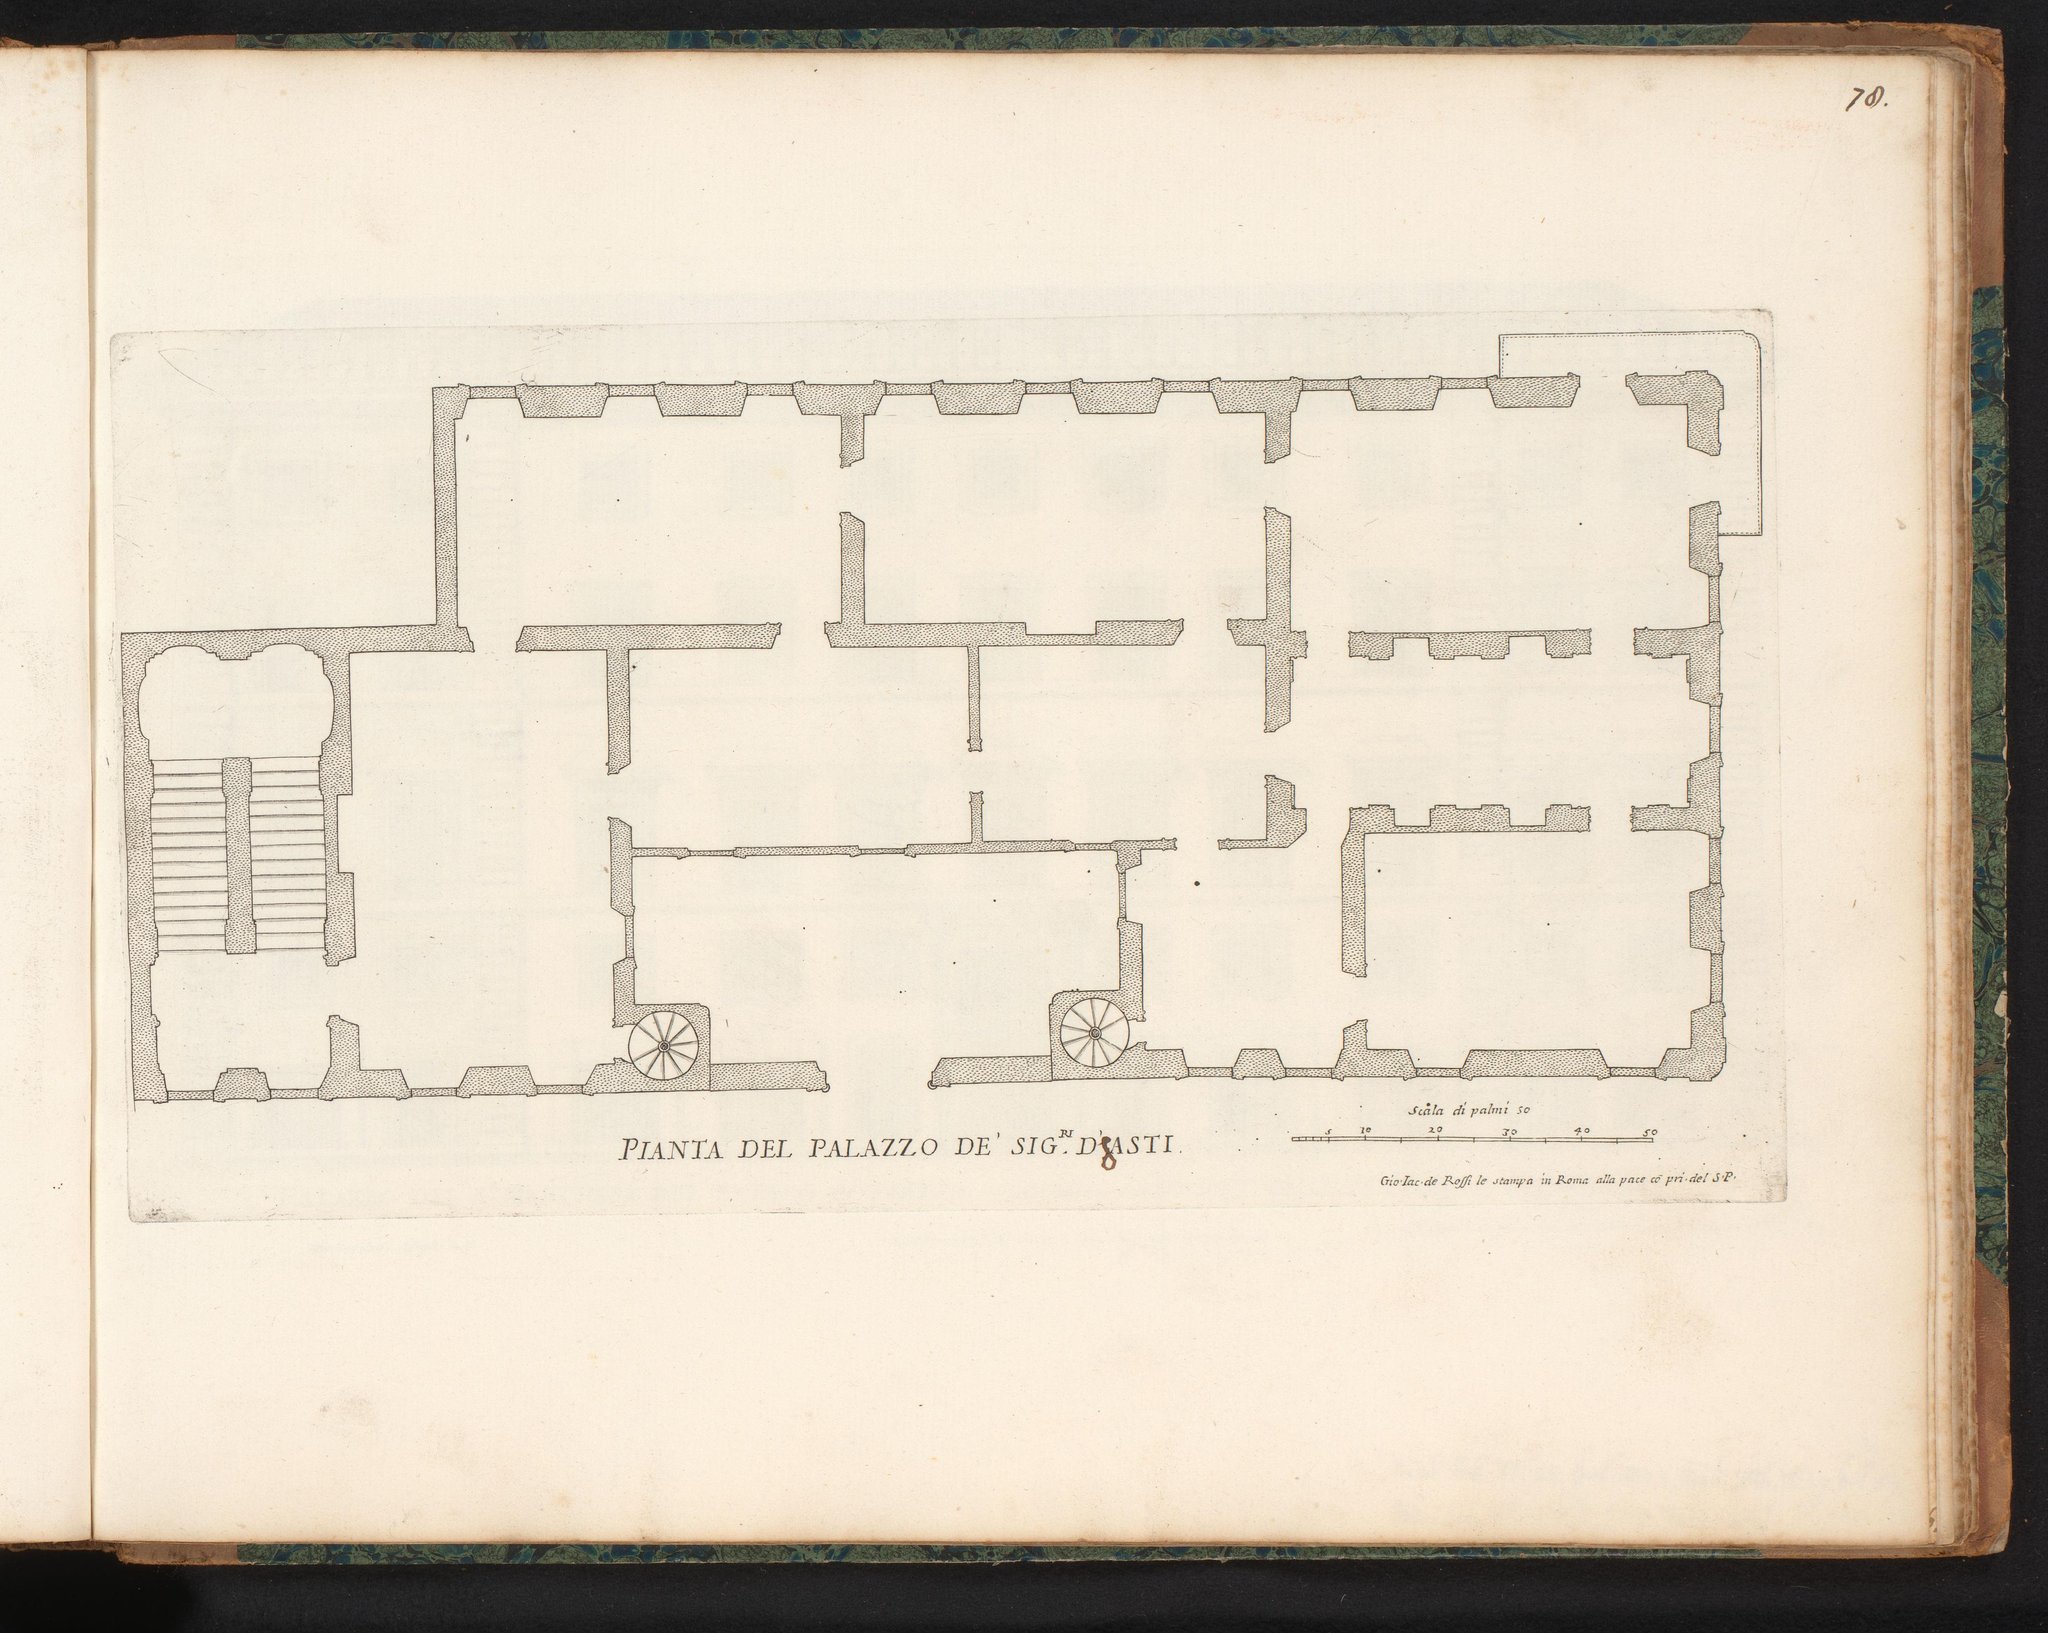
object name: print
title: Pianta del Palazzo de' sig.ri d'Asti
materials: paper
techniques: etching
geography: italy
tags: palace, plan ~ architecture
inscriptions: number: ‘78’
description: Deze prent maakt deel uit van de reeks getiteld: Palazzi di Roma. Deze reeks bestaat uit twee boeken. Boek één getiteld: Palazzi di Roma dei più celebri architetti..., bestaat uit 44 prenten die worden toegeschreven aan Giovanni Battista Falda (naam staat enkel op prent 27) en uitgegeven door Giovanni Giacomo de'Rossi. Deze 44 prenten zijn bekend in twee staten (met en zonder nummer). Boek twee getiteld: Nuovi disegni dell'architetture... libro secondo, bevat 66 prenten door Giovanni Battista Falda en Simone Felice. Deze 66 prenten zijn bekend in twee staten (met en zonder nummer).